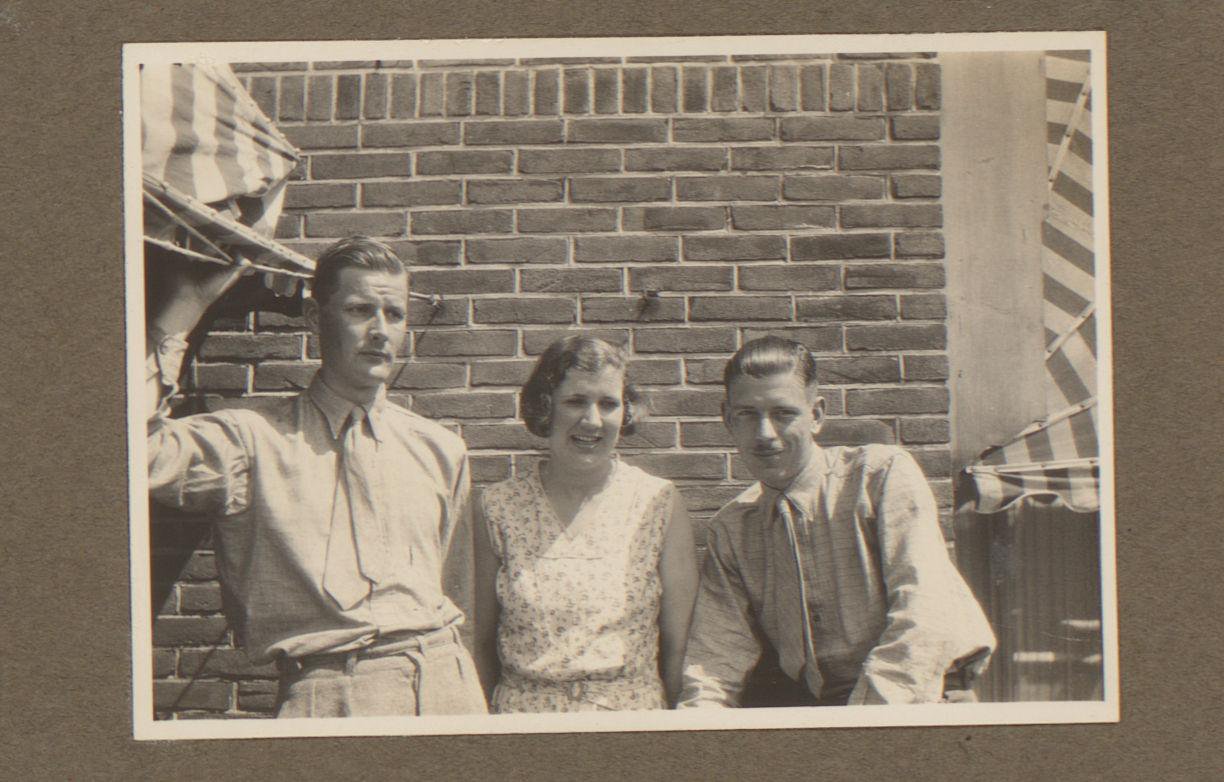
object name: photograph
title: Portret van Basil Cowper, Joyce Bailey en Cyril Barrett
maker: Anonymous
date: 1907-1932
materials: paper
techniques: gelatin silver print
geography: scheveningen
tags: historical persons - bb - woman, historical persons